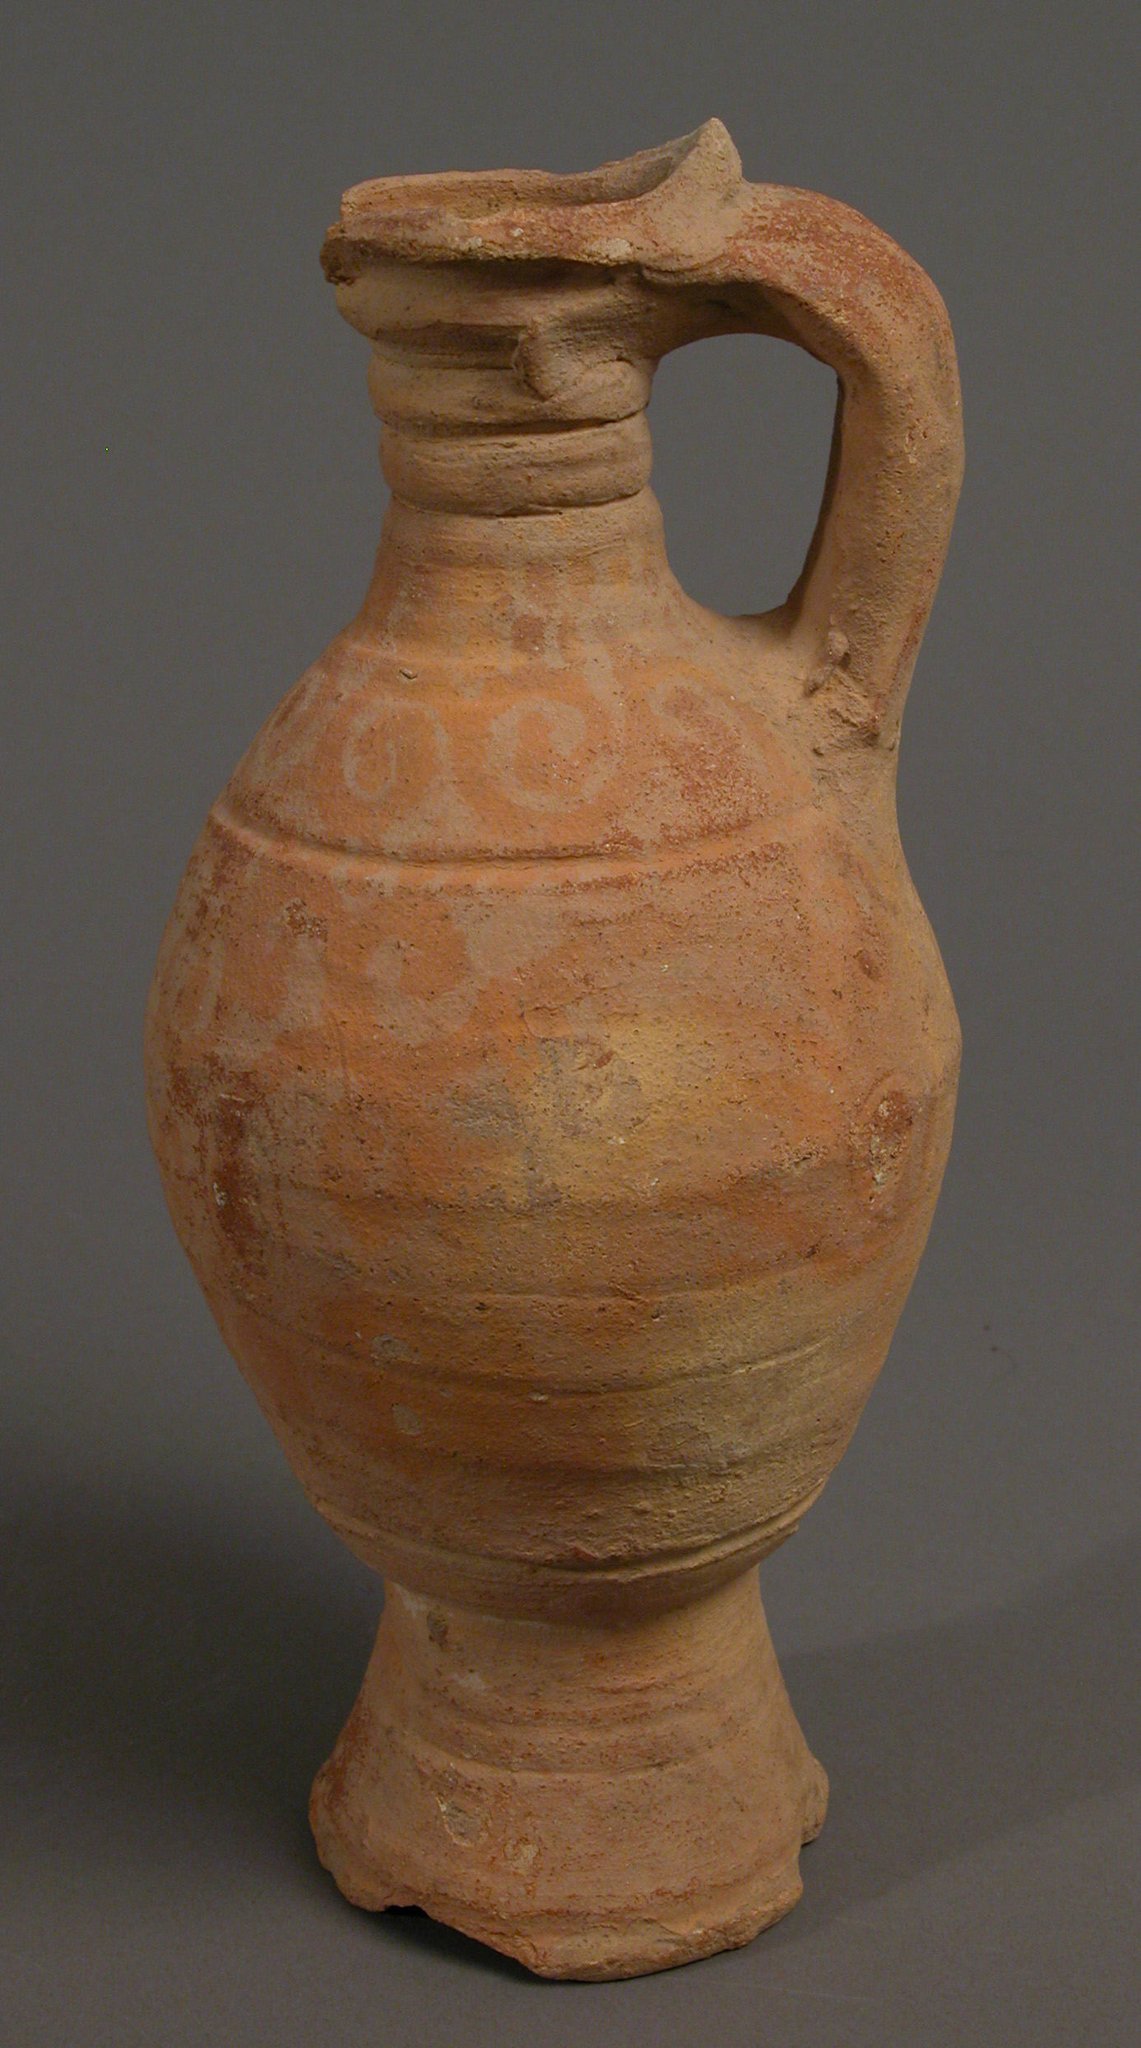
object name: jug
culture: coptic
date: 301-700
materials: earthenware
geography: egypt